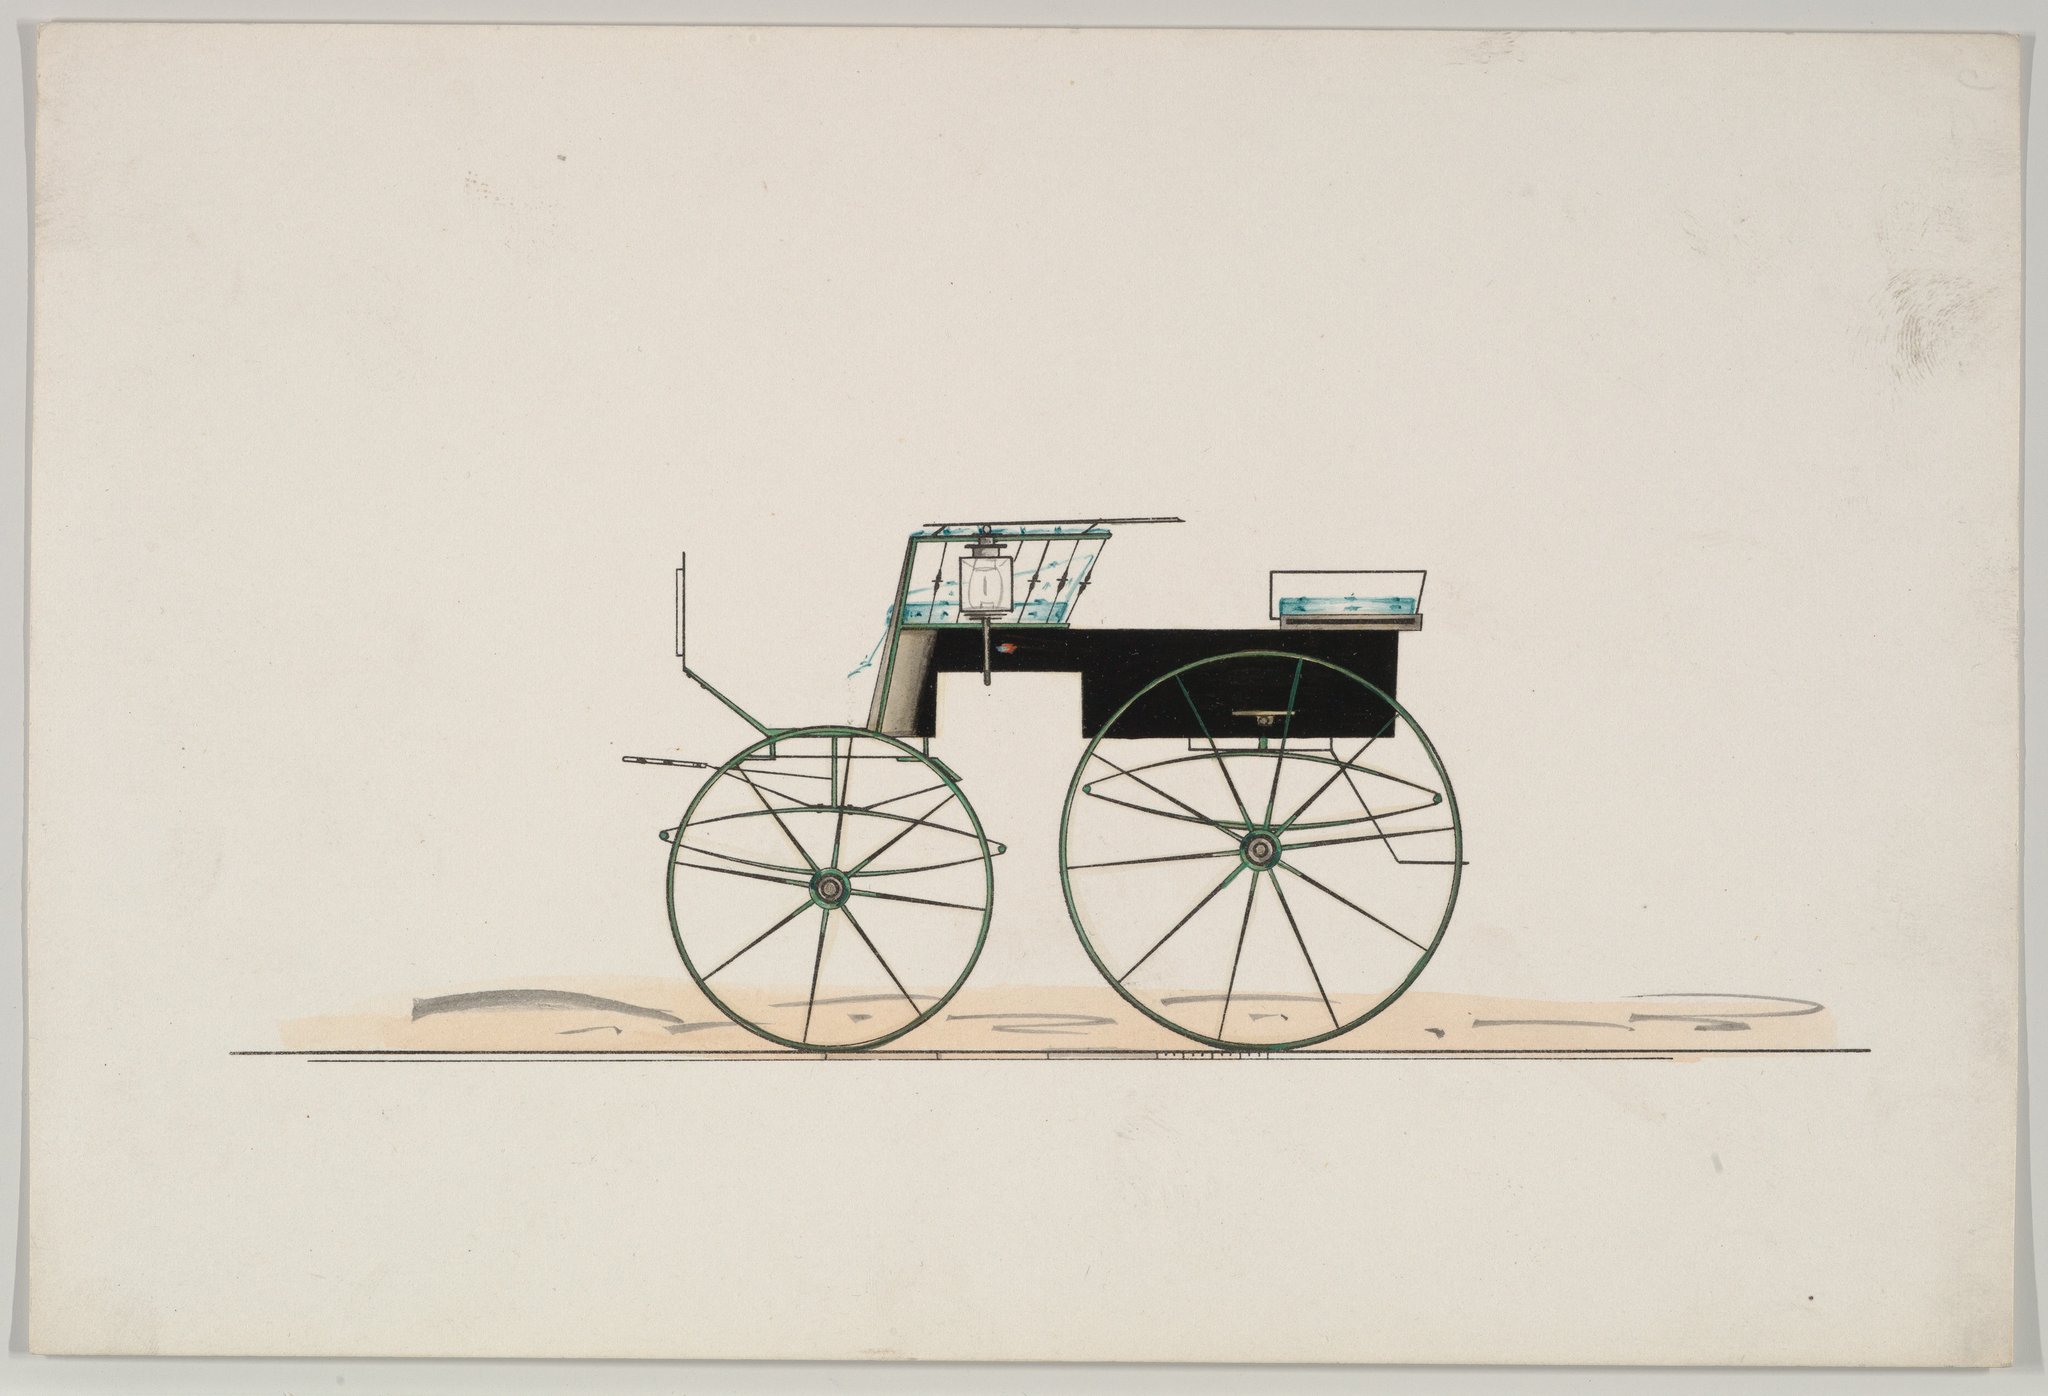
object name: drawing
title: Phaeton (unnumbered)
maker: brewster & co.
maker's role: manufacturer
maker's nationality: american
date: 1850-1870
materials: gouache, gum arabic, ink, watercolor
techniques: pen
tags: carriages